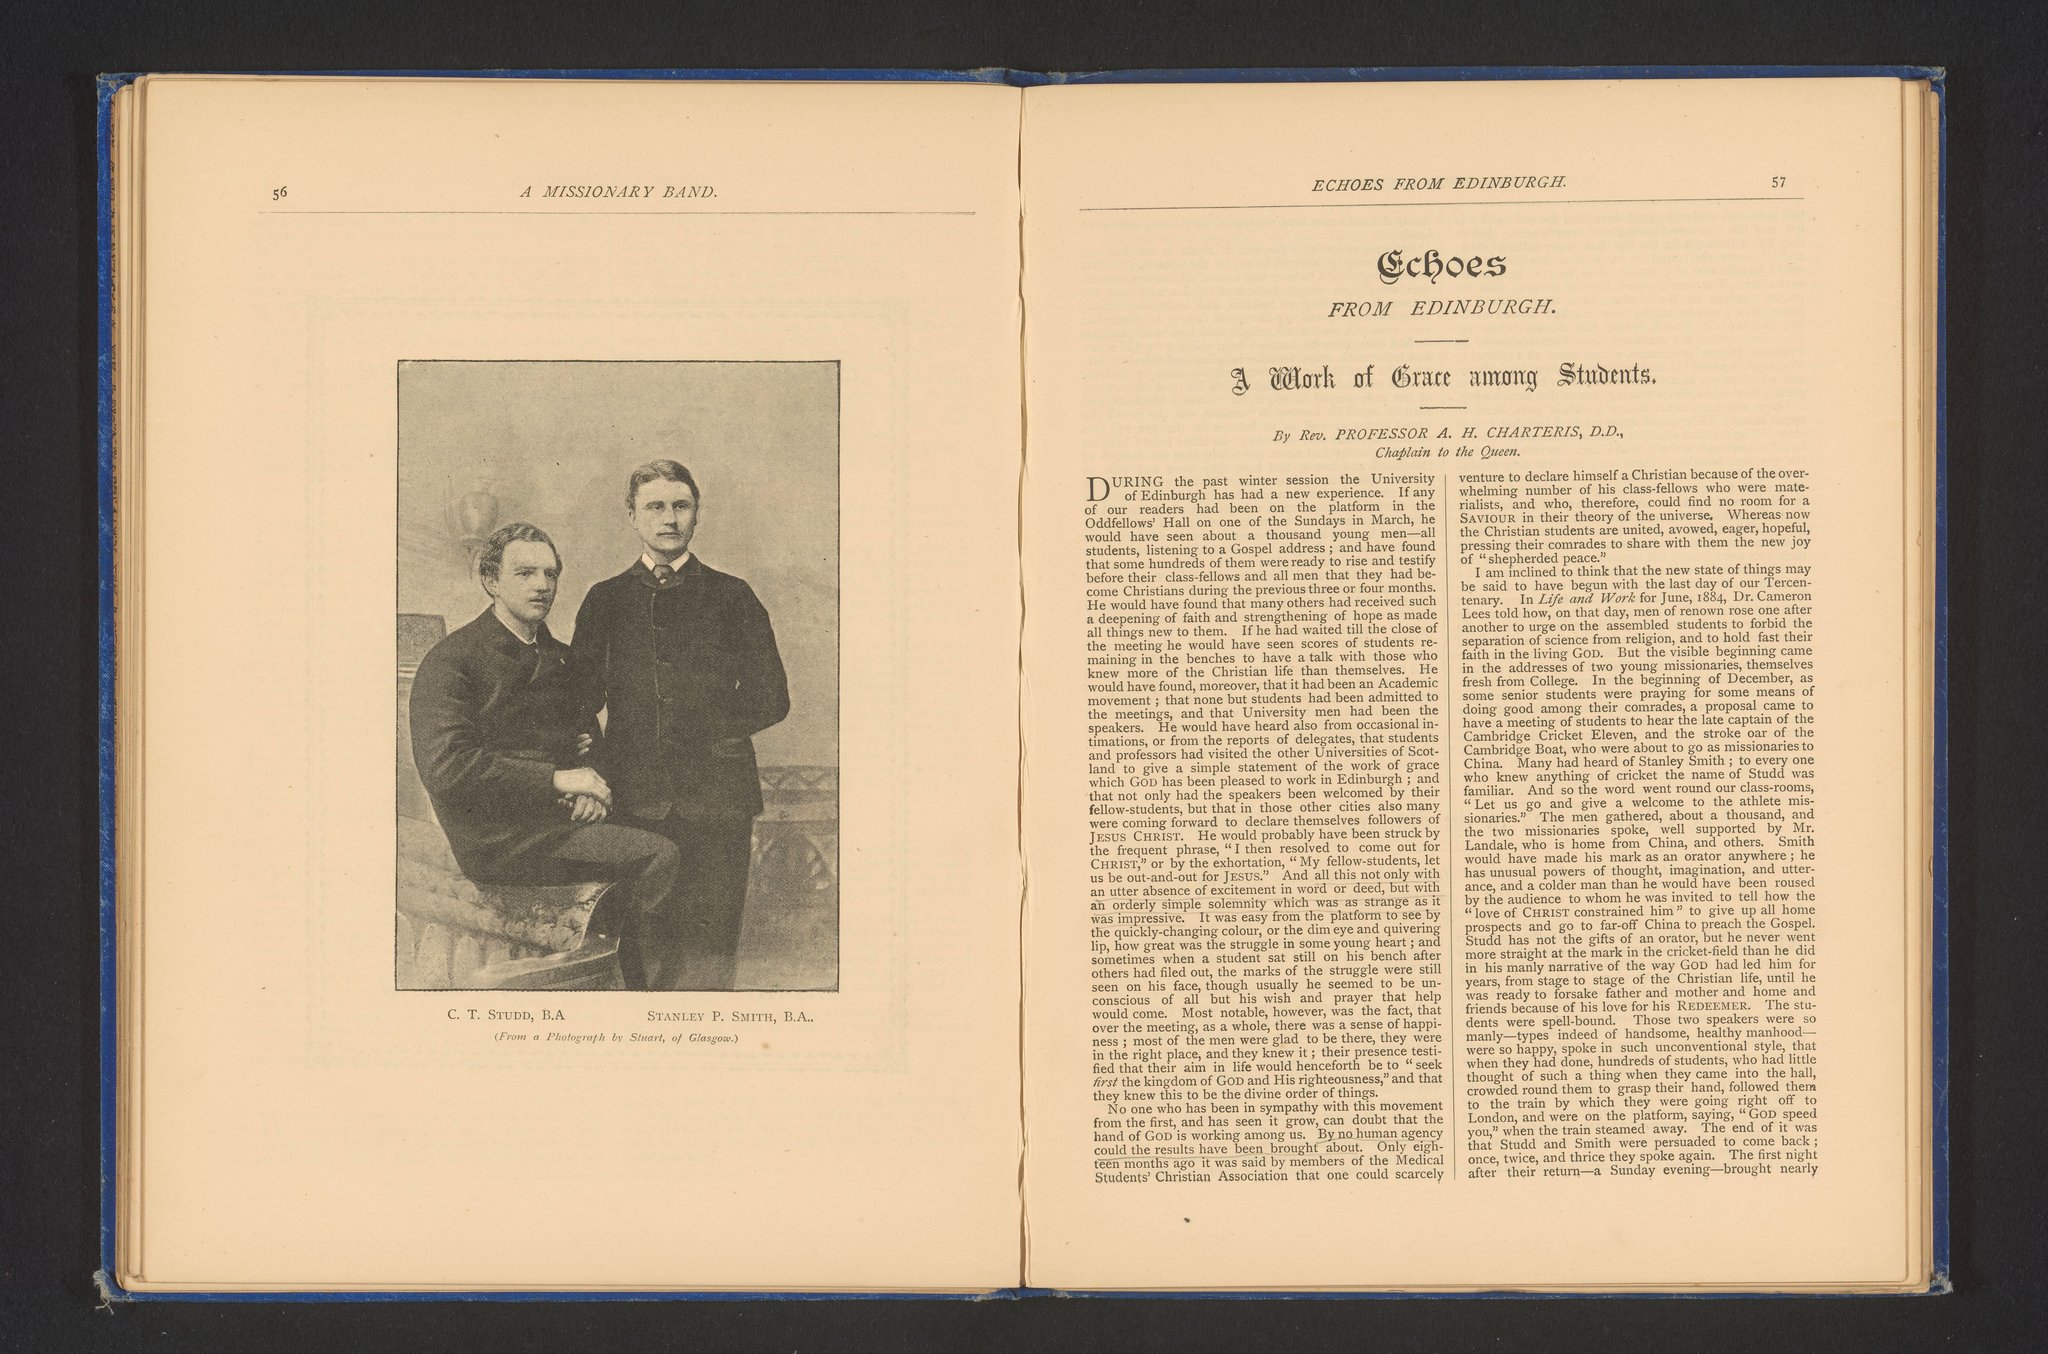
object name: page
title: Fotoreproductie van een schilderij, voorstellende een portret van Charles Studd en Stanley Smith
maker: Anonymous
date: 1881-1886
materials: paper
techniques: autotype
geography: glasgow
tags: missionary, historical persons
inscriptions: name: ‘C.T. Studd, B.A. Stanley P. Smith, B.A.’